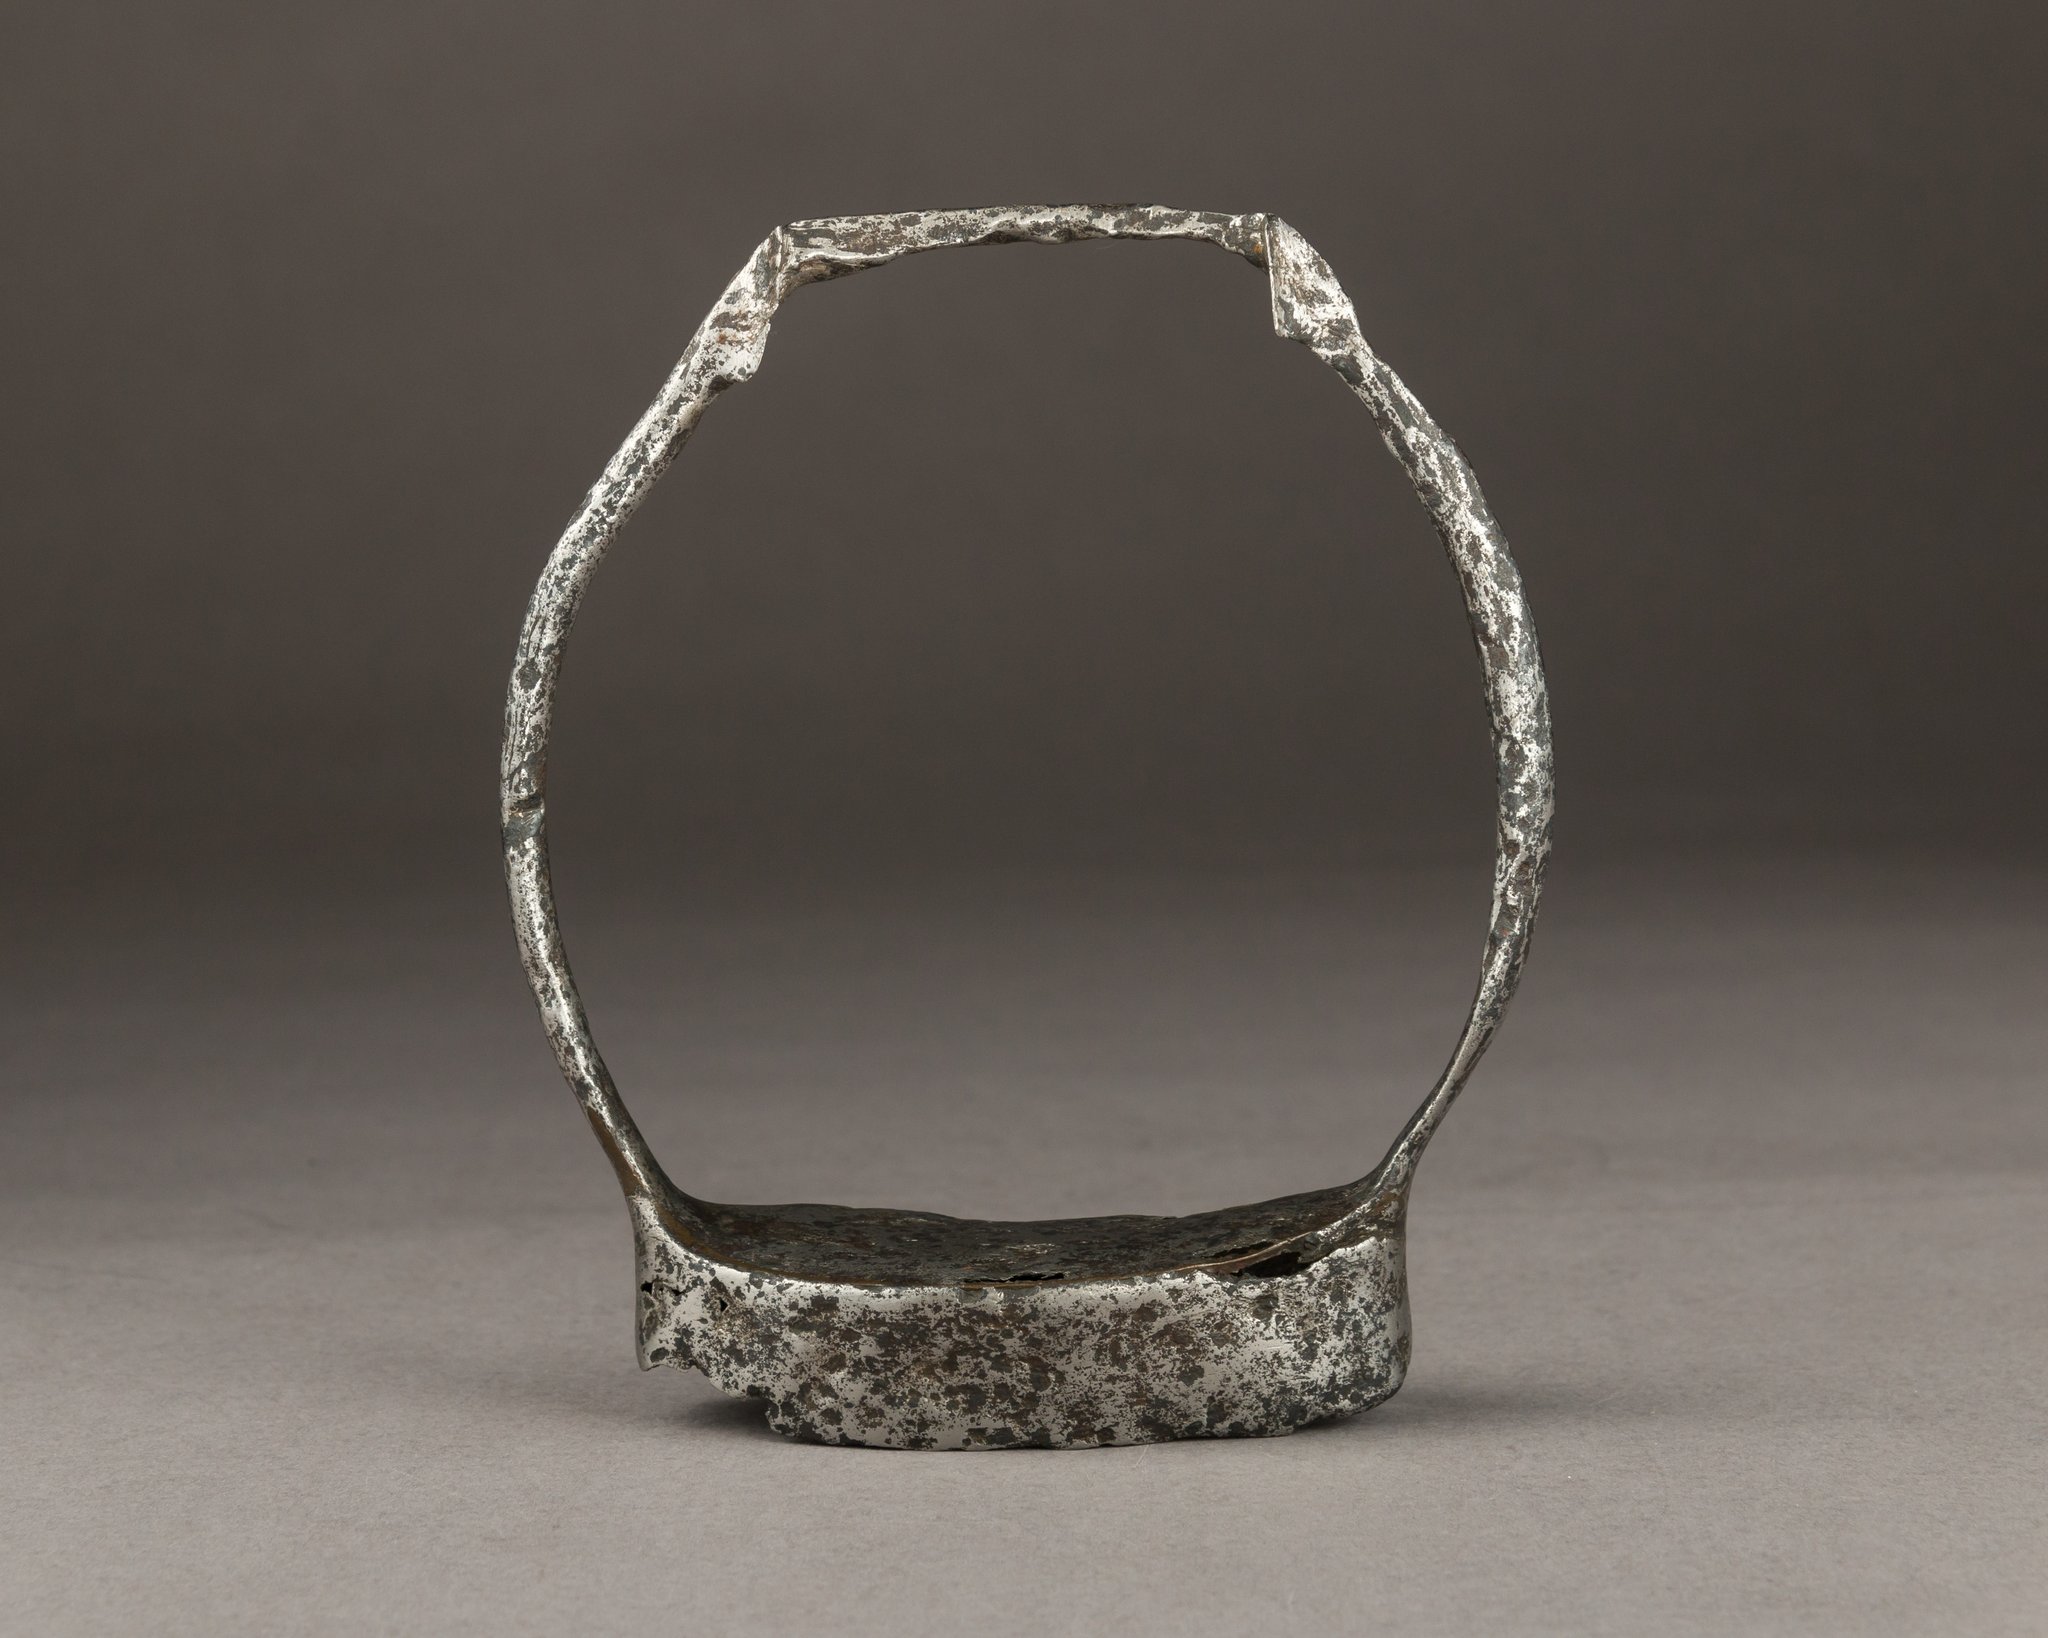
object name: stirrup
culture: hungarian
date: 1401-1500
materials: iron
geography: hungary